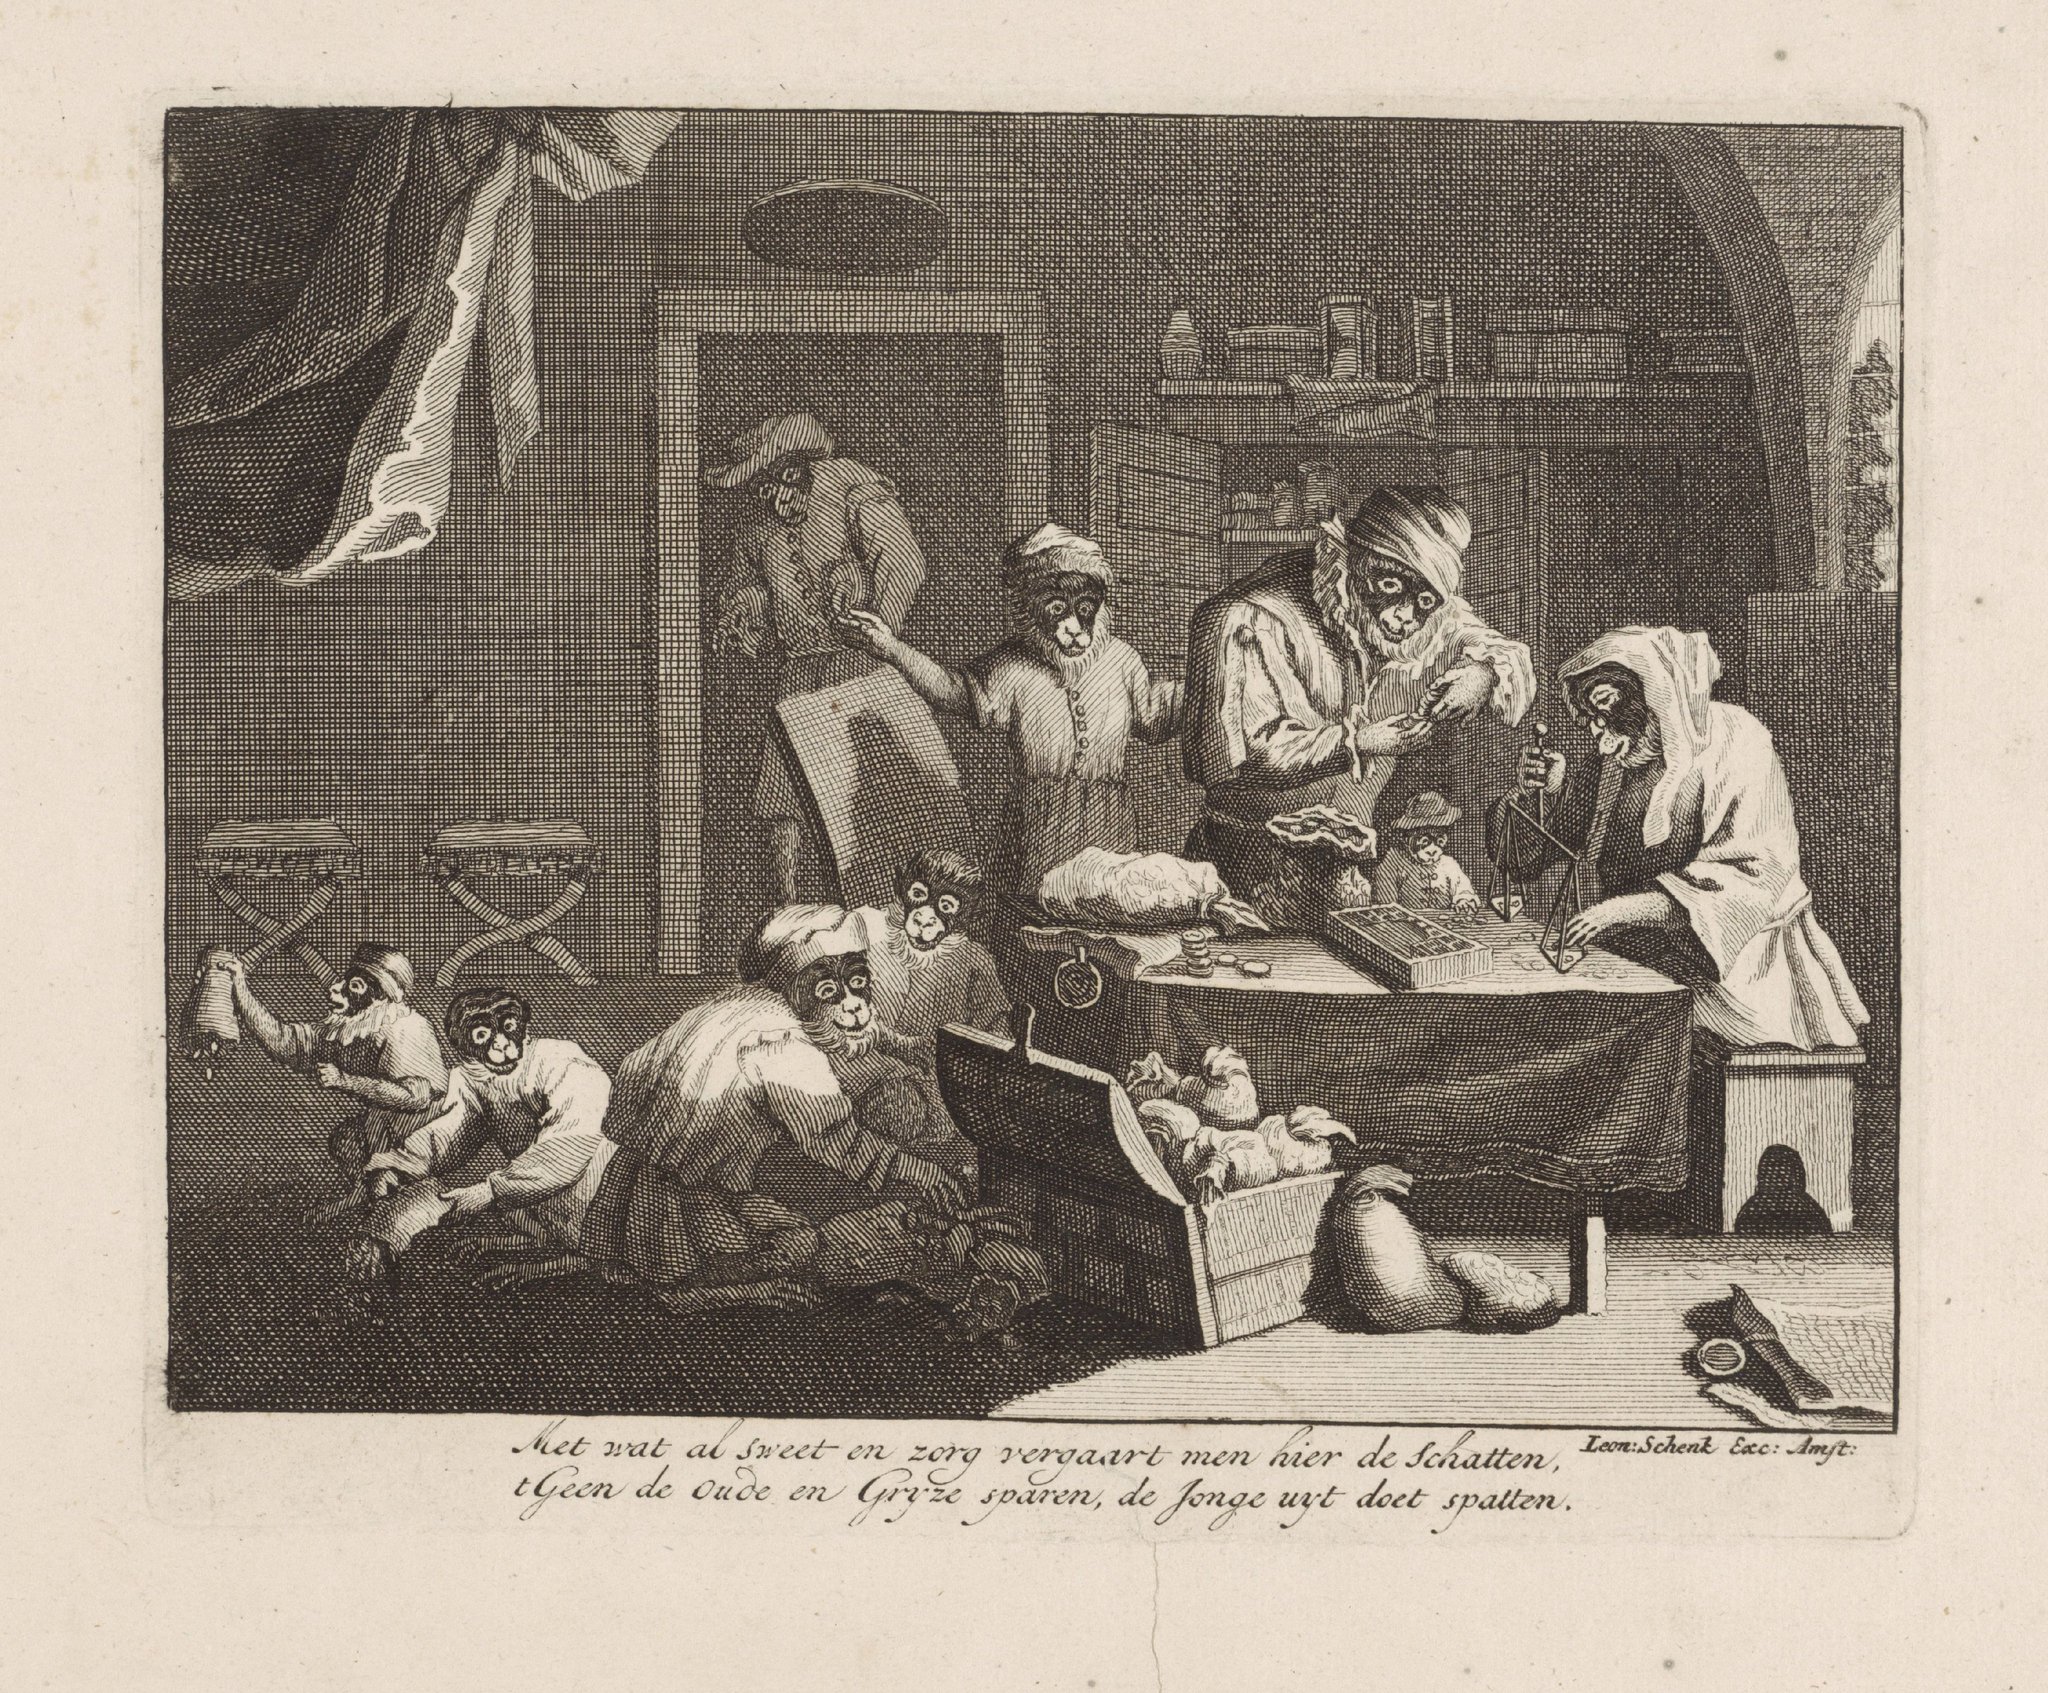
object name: print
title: Apenspel in de wereld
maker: leonard schenk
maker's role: print maker, publisher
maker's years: 1696-1767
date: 1720-1767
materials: paper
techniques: etching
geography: amsterdam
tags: monkeys, apes, animals acting as human beings, weighing gold or money, money-chest, treasure-chest, money-box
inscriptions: collector's mark: Lugt 2228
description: In een vertrek wegen en tellen oude, bankierende apen geld. De geldstukken worden opgeborgen in geldzakken in een schatkist. Jonge apen gooien het geld op de grond. Onderdeel van een serie bestaande uit een titelprent en platen waarin apen als mensen figureren in allerlei taferelen uit het dagelijks leven. De prent heeft een tweeregelig vers in het Nederlands.